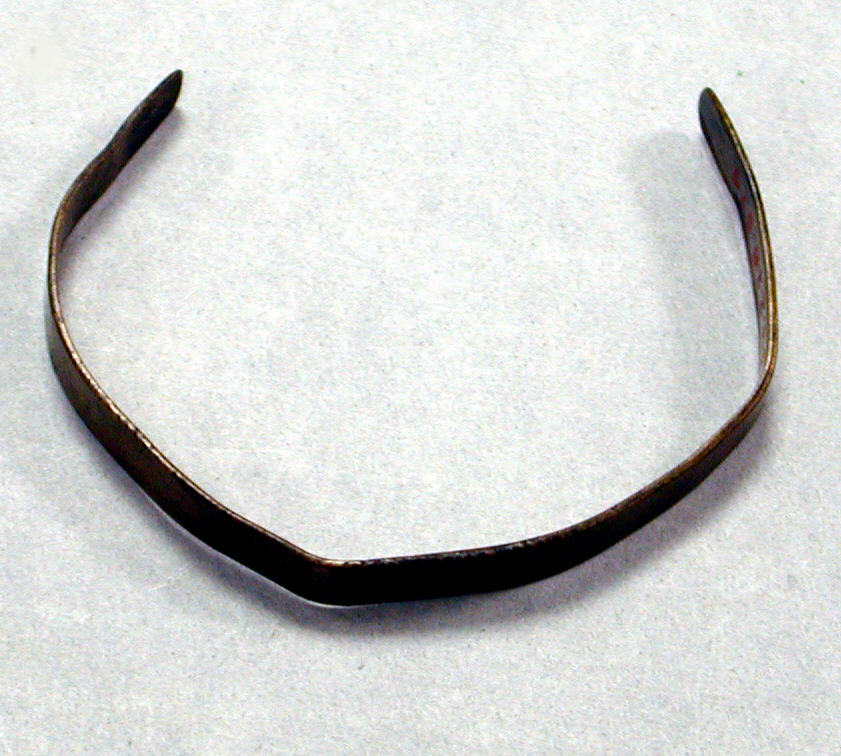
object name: ornament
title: Hammered Copper Band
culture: peruvian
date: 1450-1530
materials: copper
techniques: hammering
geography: peru